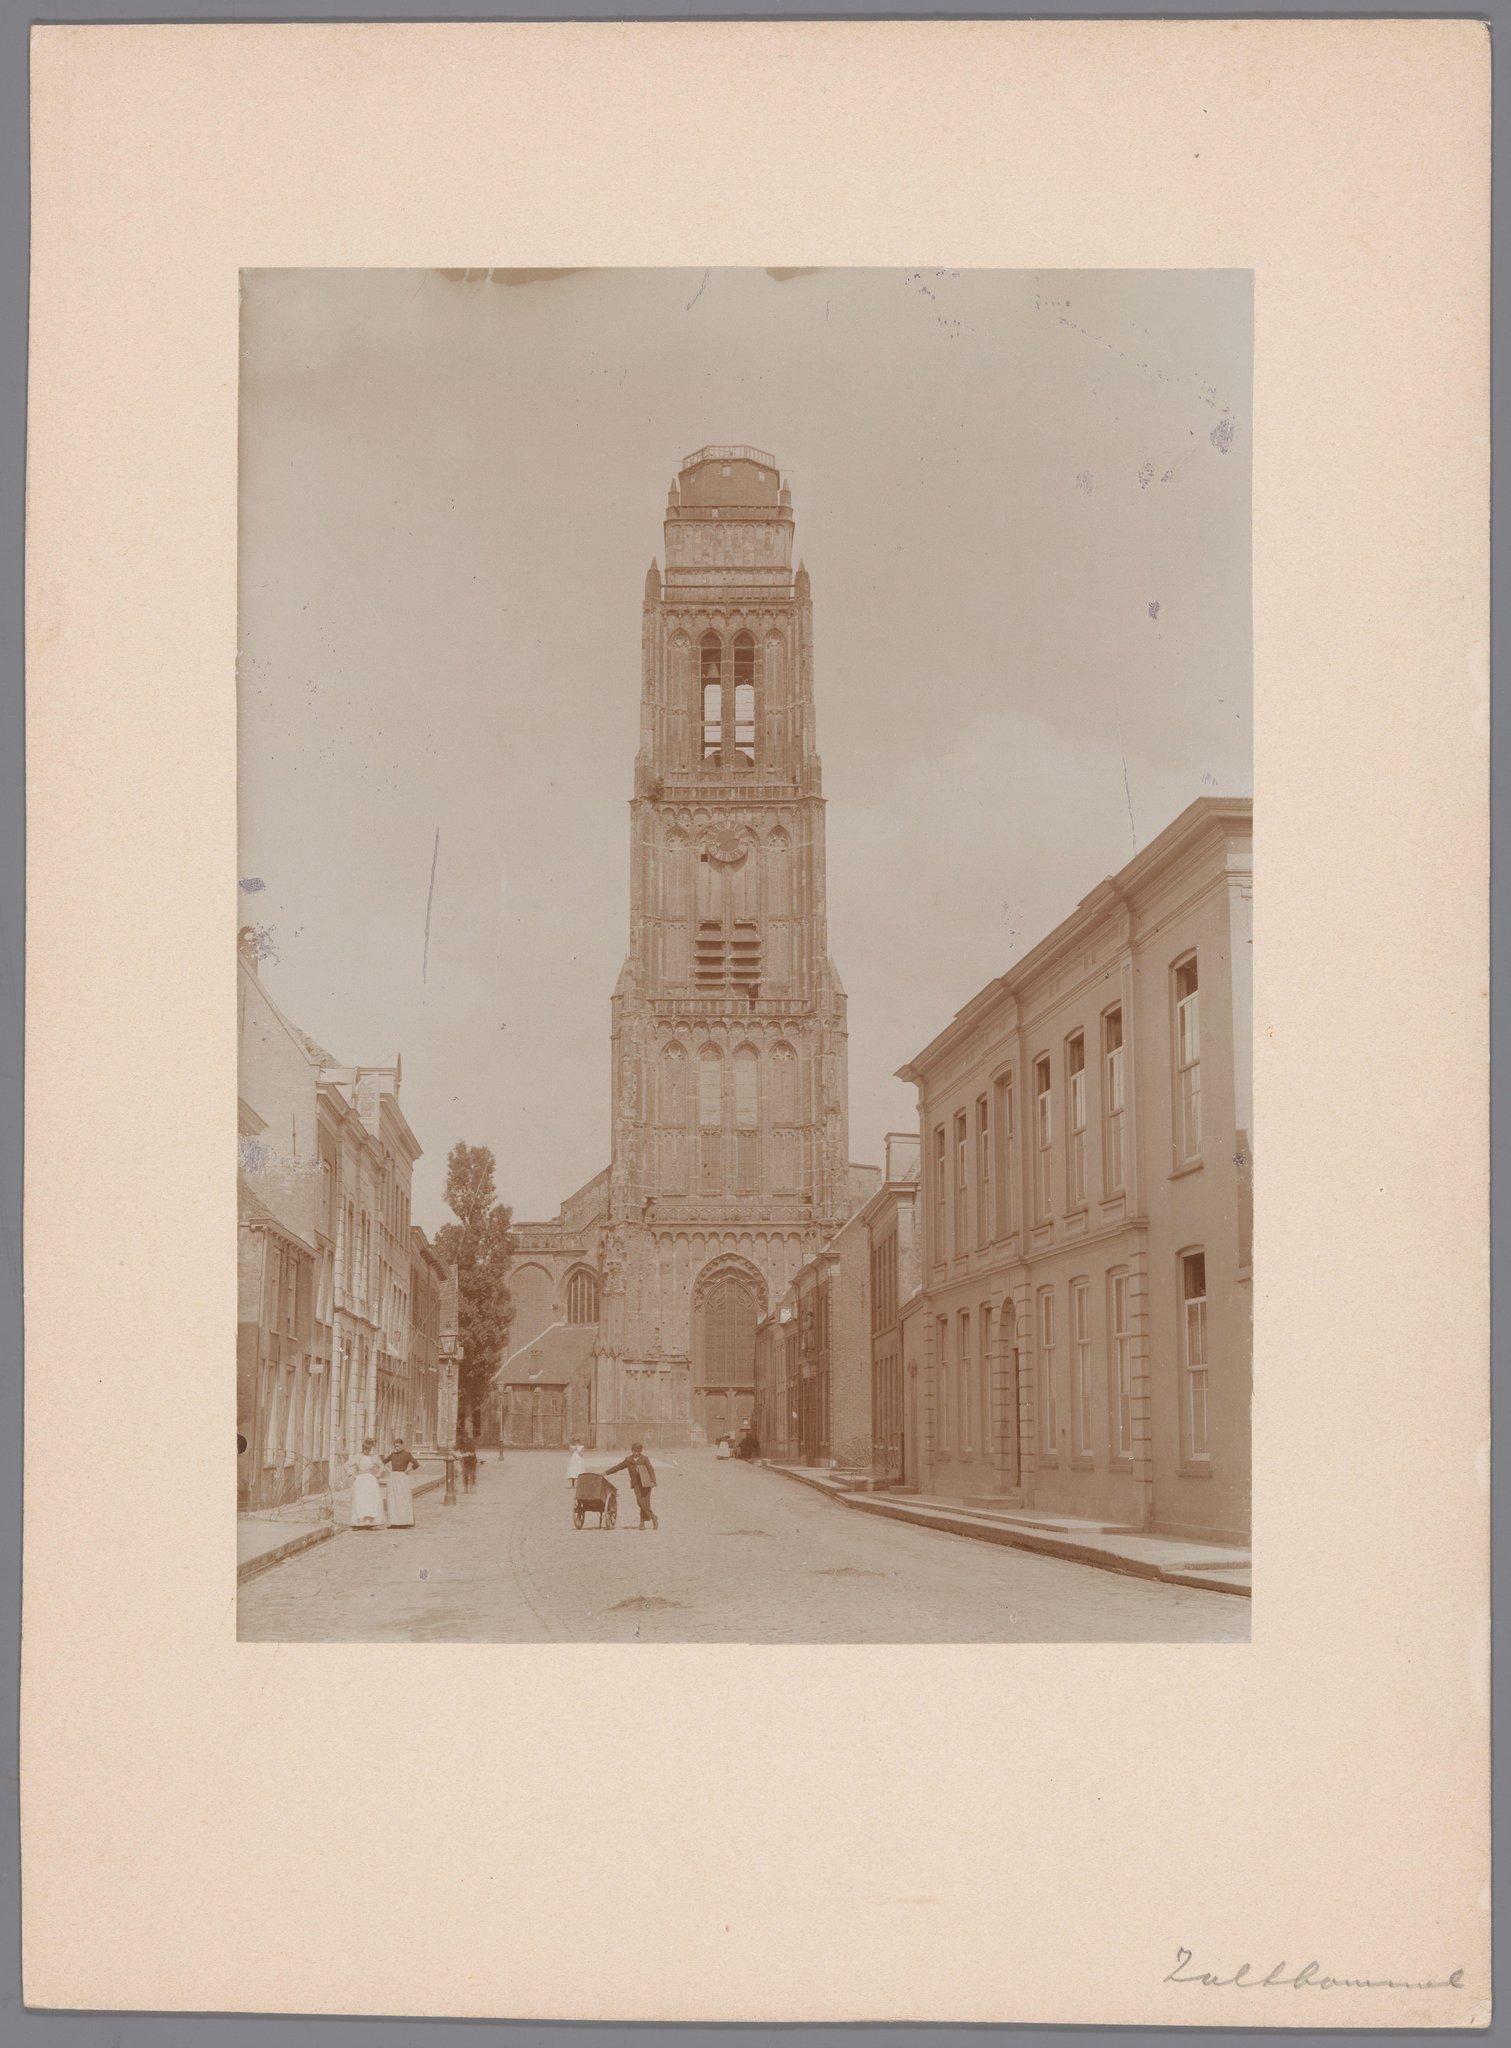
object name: photograph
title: Toren van de Grote of Sint-Maartenskerk te Zaltbommel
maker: anoniem (monumentenzorg)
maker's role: fotograaf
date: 1904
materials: cardboard, photographic support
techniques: collodion silver print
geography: zaltbommel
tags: street (+ city(-scape) with figures, staffage), parts of church exterior and annexes: tower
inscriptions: annotation: ‘Zaltbommel’, annotation: ‘Zalt Bommel (G.)/ Toren 1904’